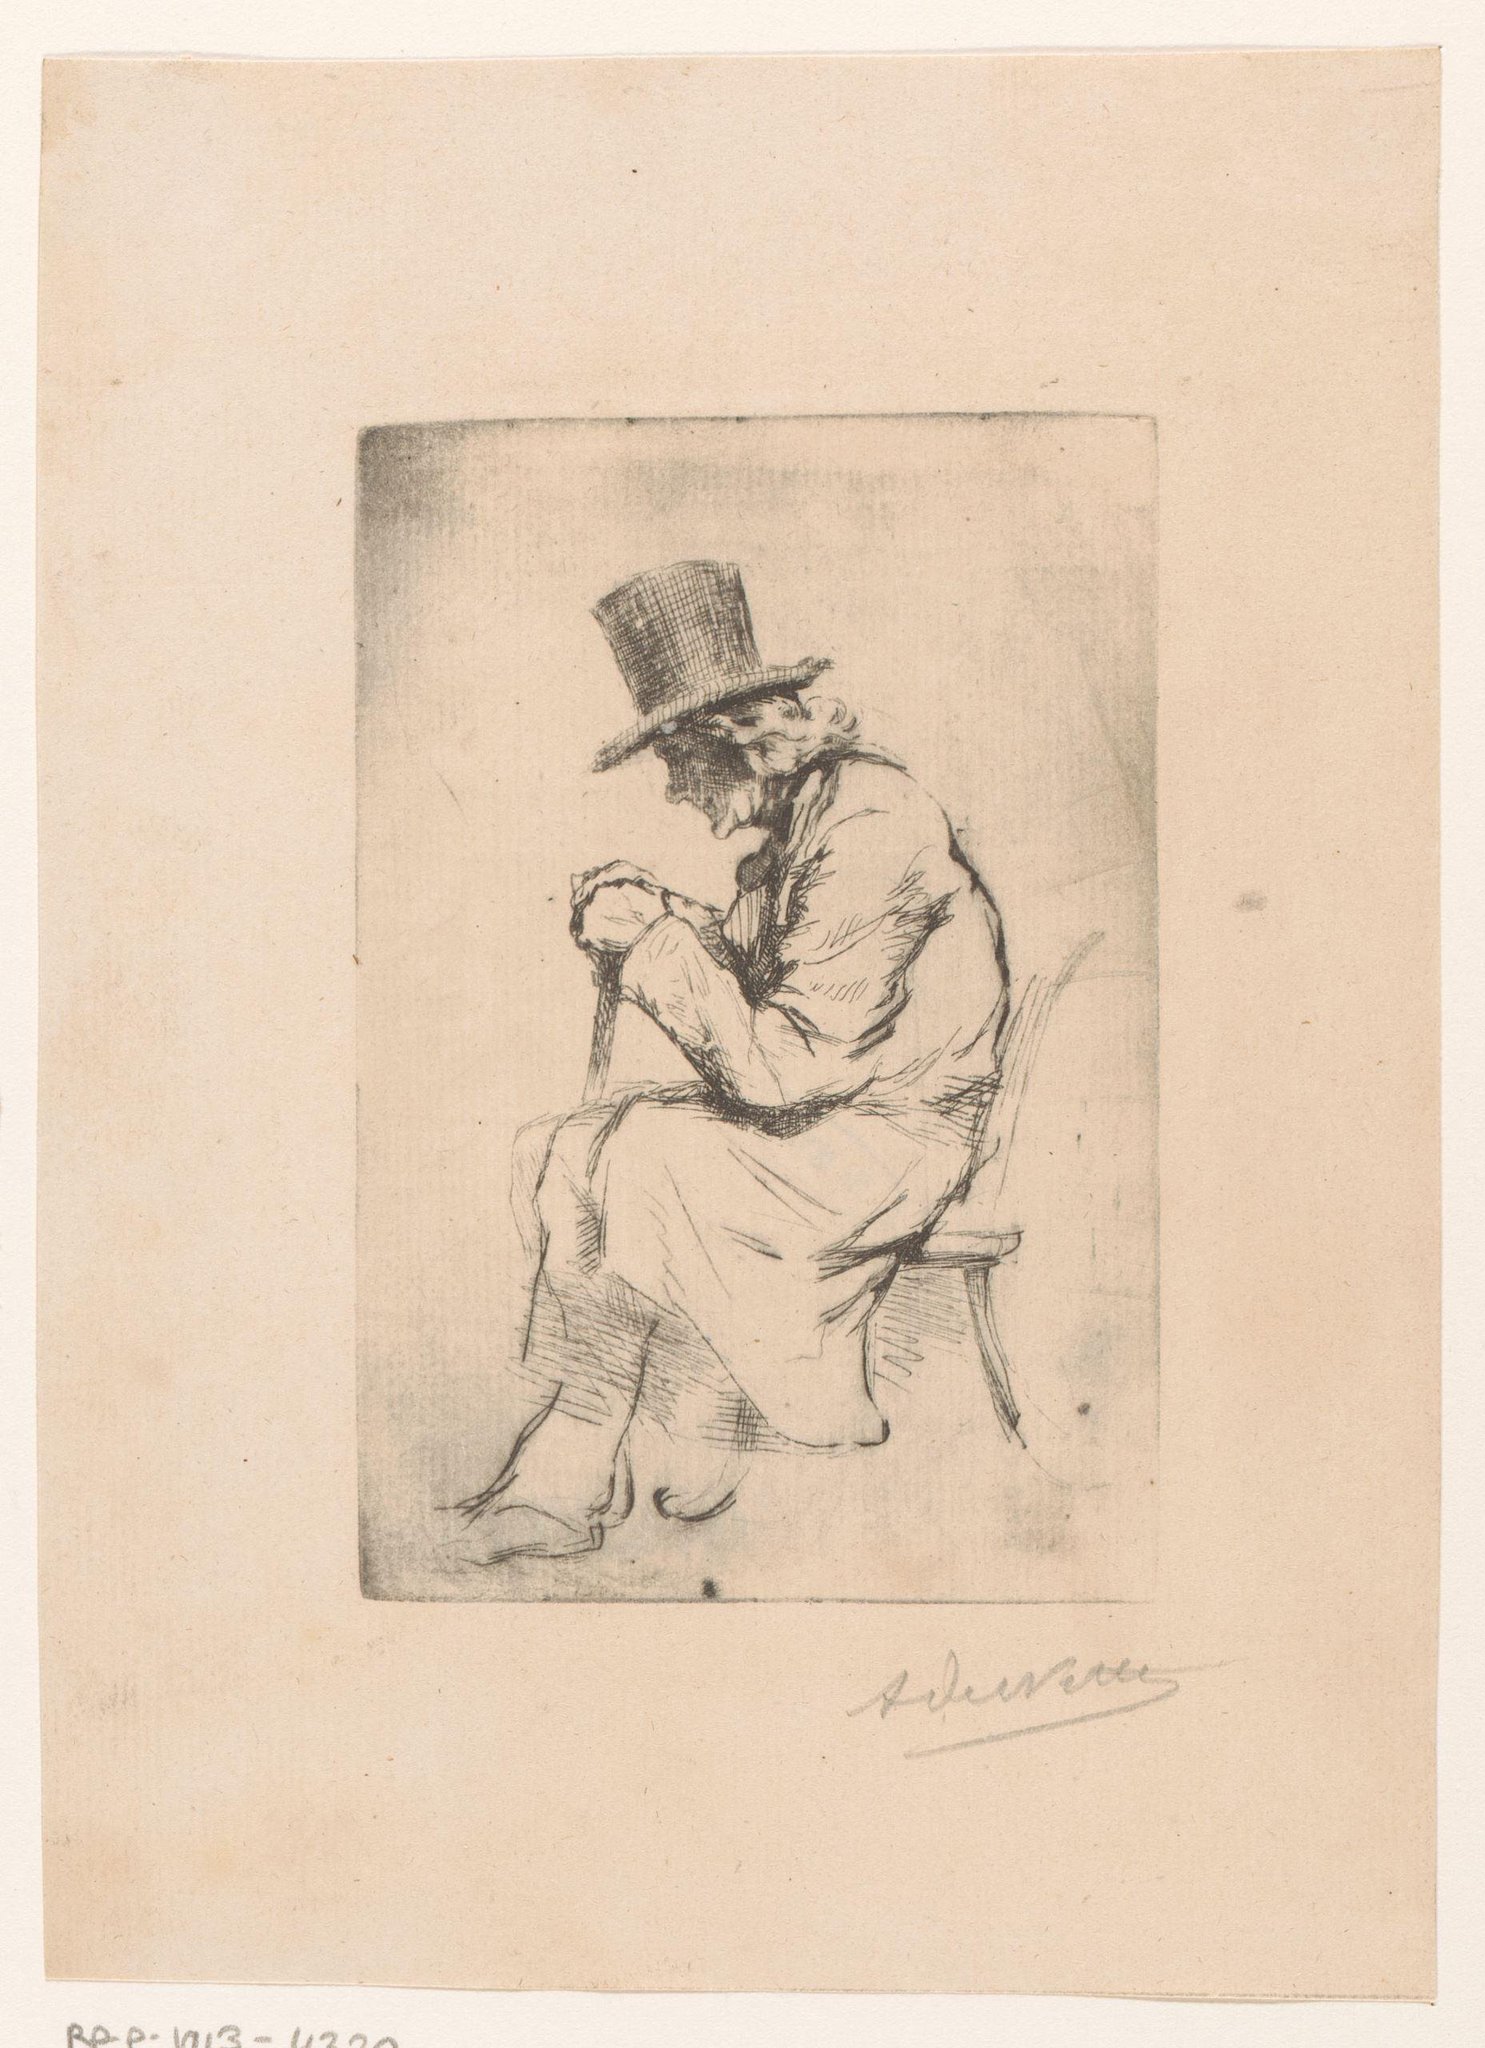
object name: print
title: Oude man met hoed en wandelstok gezeten op een stoel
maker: adrien de witte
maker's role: print maker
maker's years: 1850-1935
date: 1875-1876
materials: paper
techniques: drypoint, etching, intaglio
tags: sitting figure, walking-stick, staff, old man, head-gear: hat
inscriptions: collector's mark: Lugt 2228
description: Latere staat van deze prent verschenen in: Rops, Félicien (red.). Cahier d'études: eaux-fortes originales et inédites. Brussel: Felix Callewaert père, 1875.